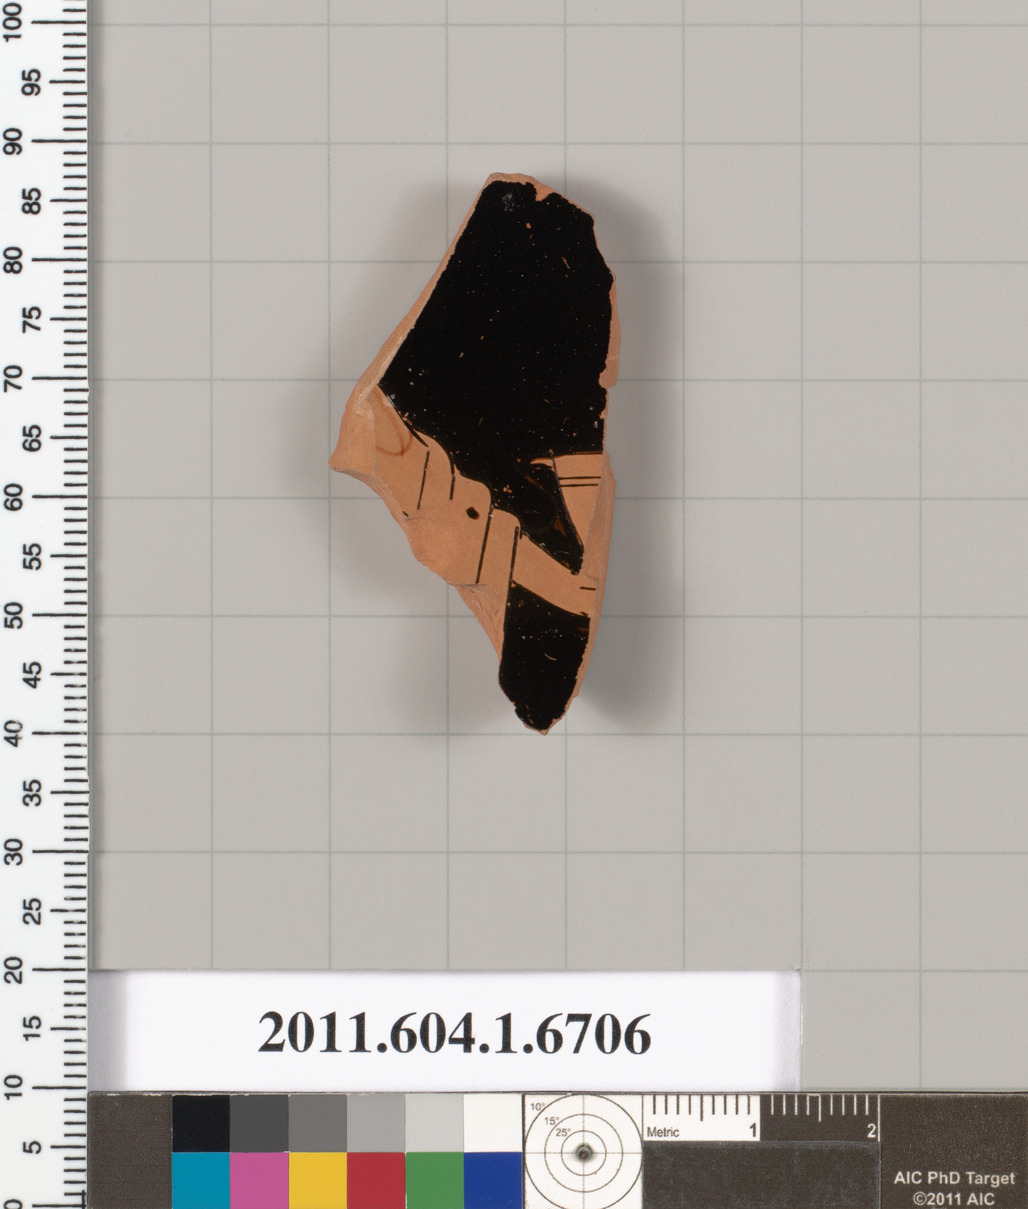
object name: kylix fragment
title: Terracotta fragment of a kylix (drinking cup)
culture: greek, attic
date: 490-470 BCE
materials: terracotta